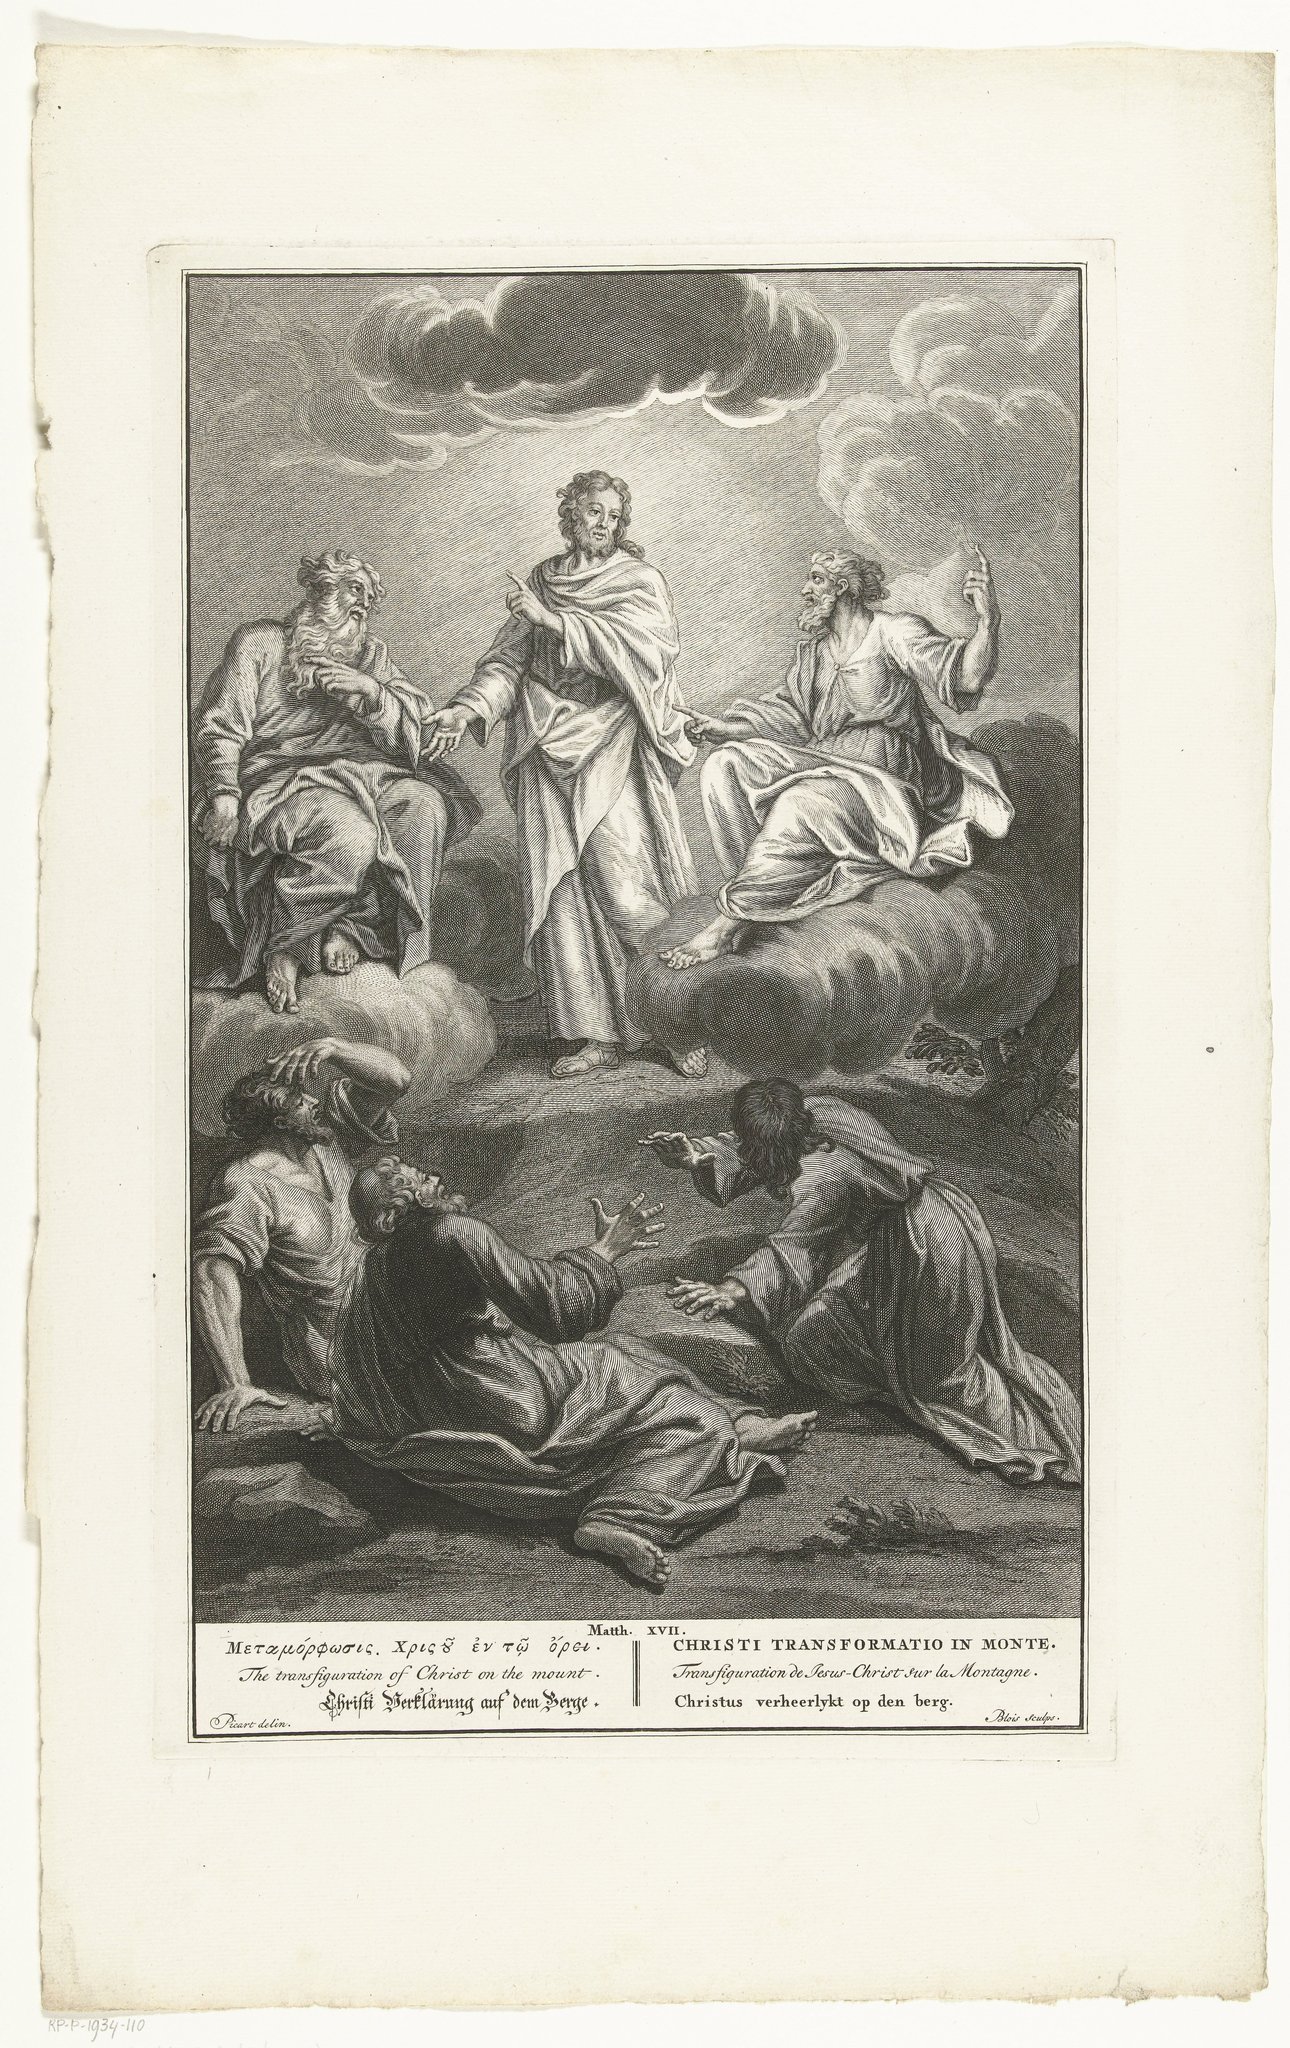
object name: print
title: Transfiguratie van Christus op de berg Tabor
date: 1679-1717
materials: paper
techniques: engraving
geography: amsterdam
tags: the transfiguration: moses and elijah appear on either side of christ on mount tabor (matthew 17:1-13; mark 9:2-13; luke 9:28-36)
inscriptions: collector's mark: Lugt 2228, inscription: ‘utrechts Fundatie huijs’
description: Prent voor: Hoet, Gerard, Taferelen der voornaamste geschiedenissen van het Oude en Nieuwe Testament, en andere boeken, bij de Heilige Schrift gevoegt, door Hoet, Houbraken, en Picart getekent en van de beste meesters in koper gesneden en met beschrijvingen uitgebreid, 3 delen, 's-Gravenhage, Pieter de Hondt, 1728